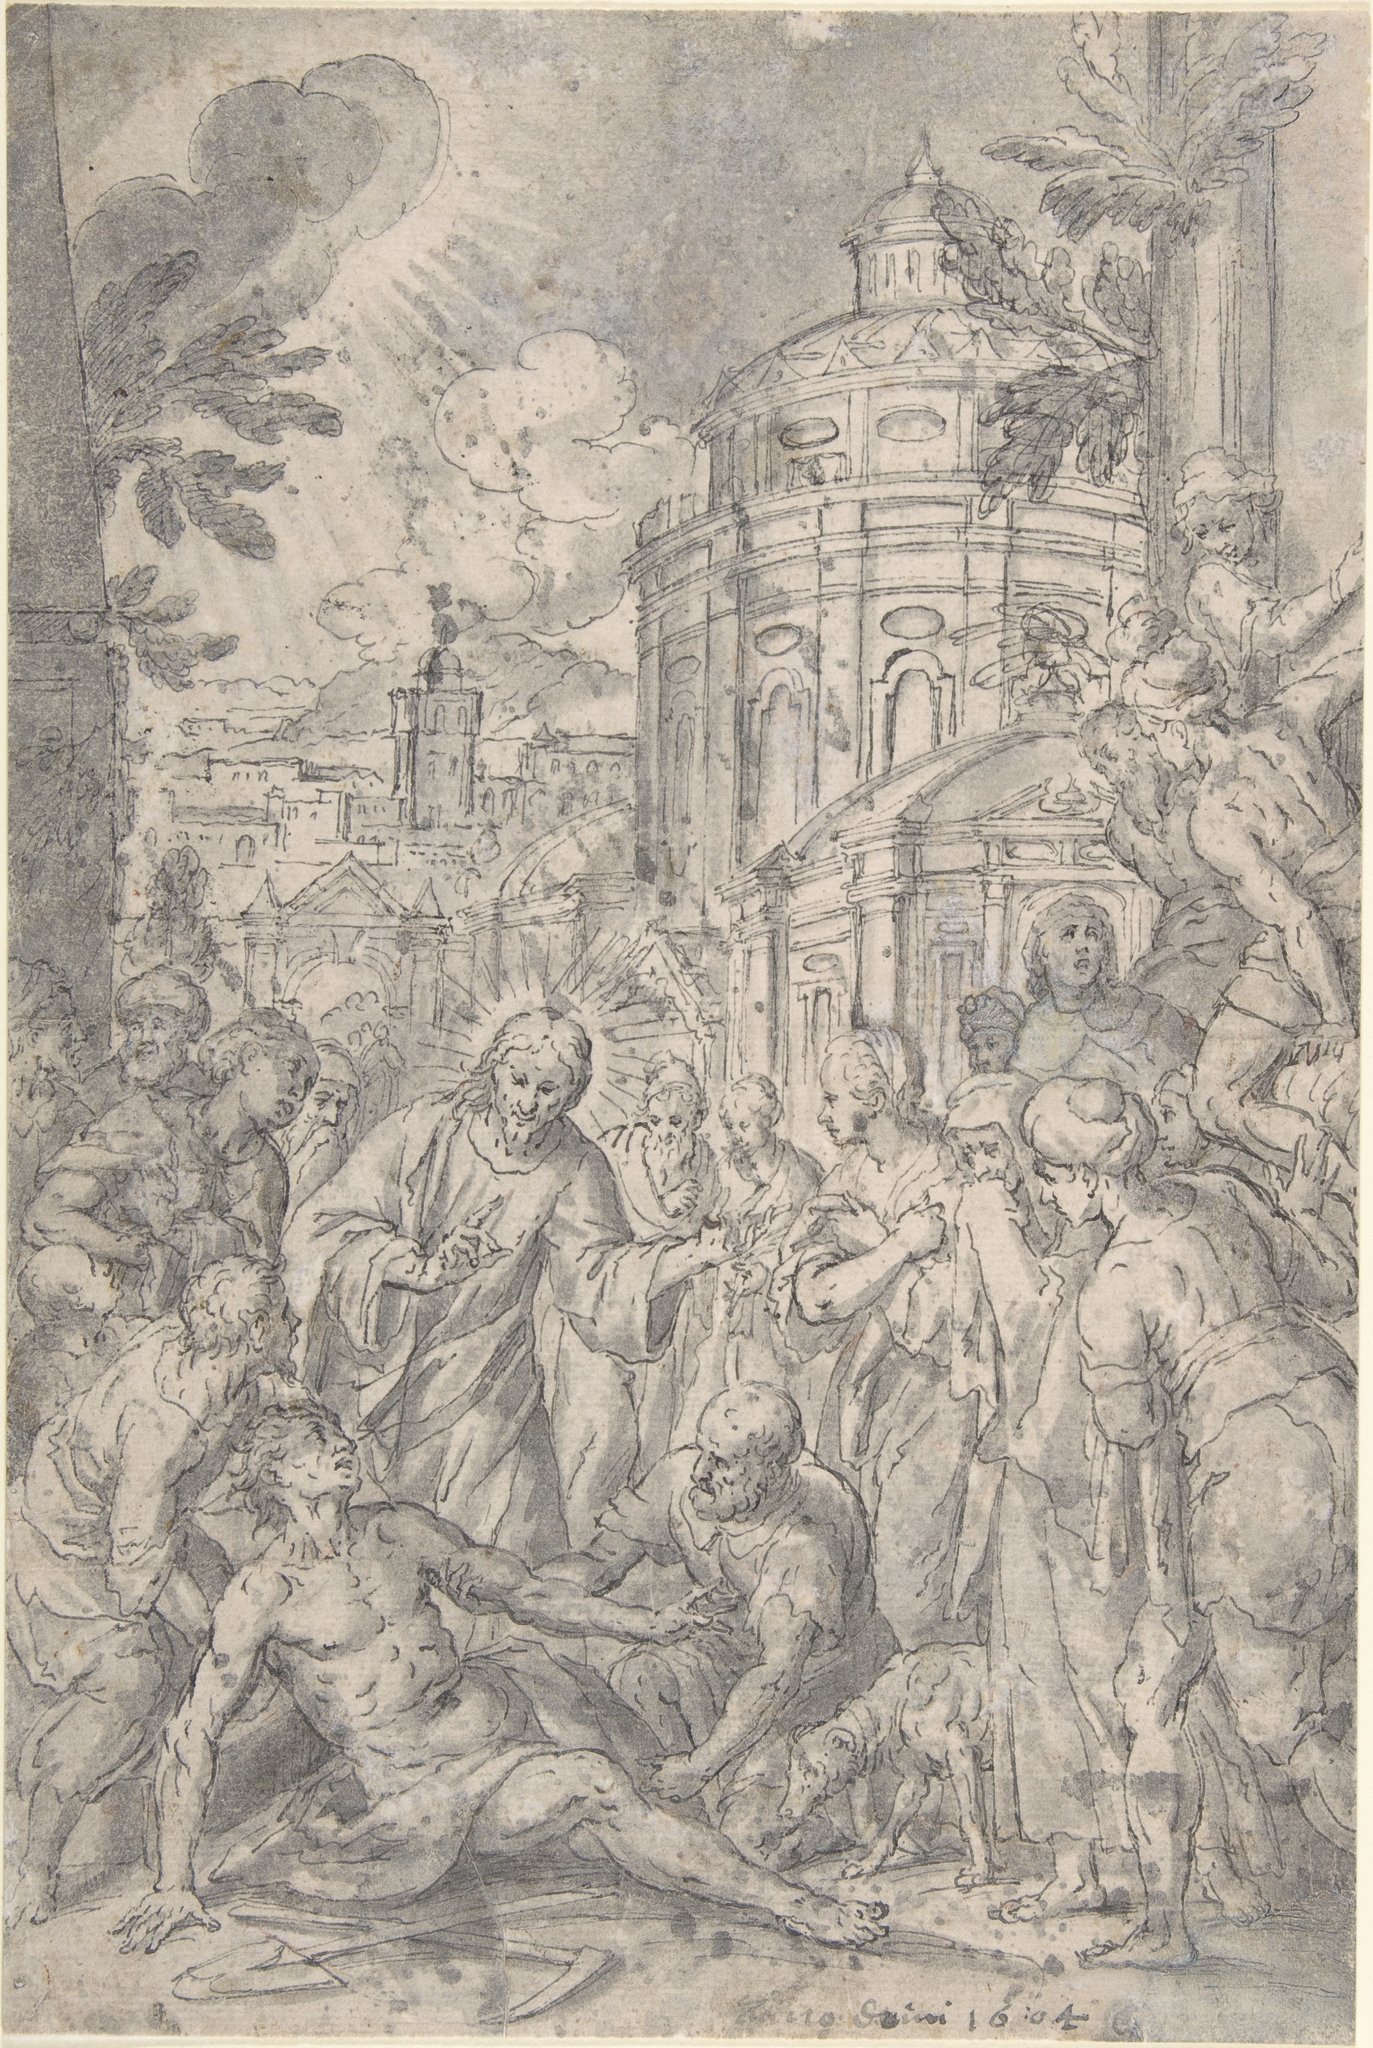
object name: drawing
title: The Raising of the Youth of Naim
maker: georg pecham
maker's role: artist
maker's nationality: german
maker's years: 1568-1604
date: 1567-1633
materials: ink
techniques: printmaking, drawing, pen, wash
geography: germany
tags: animals,male nudes,jesus,crowd